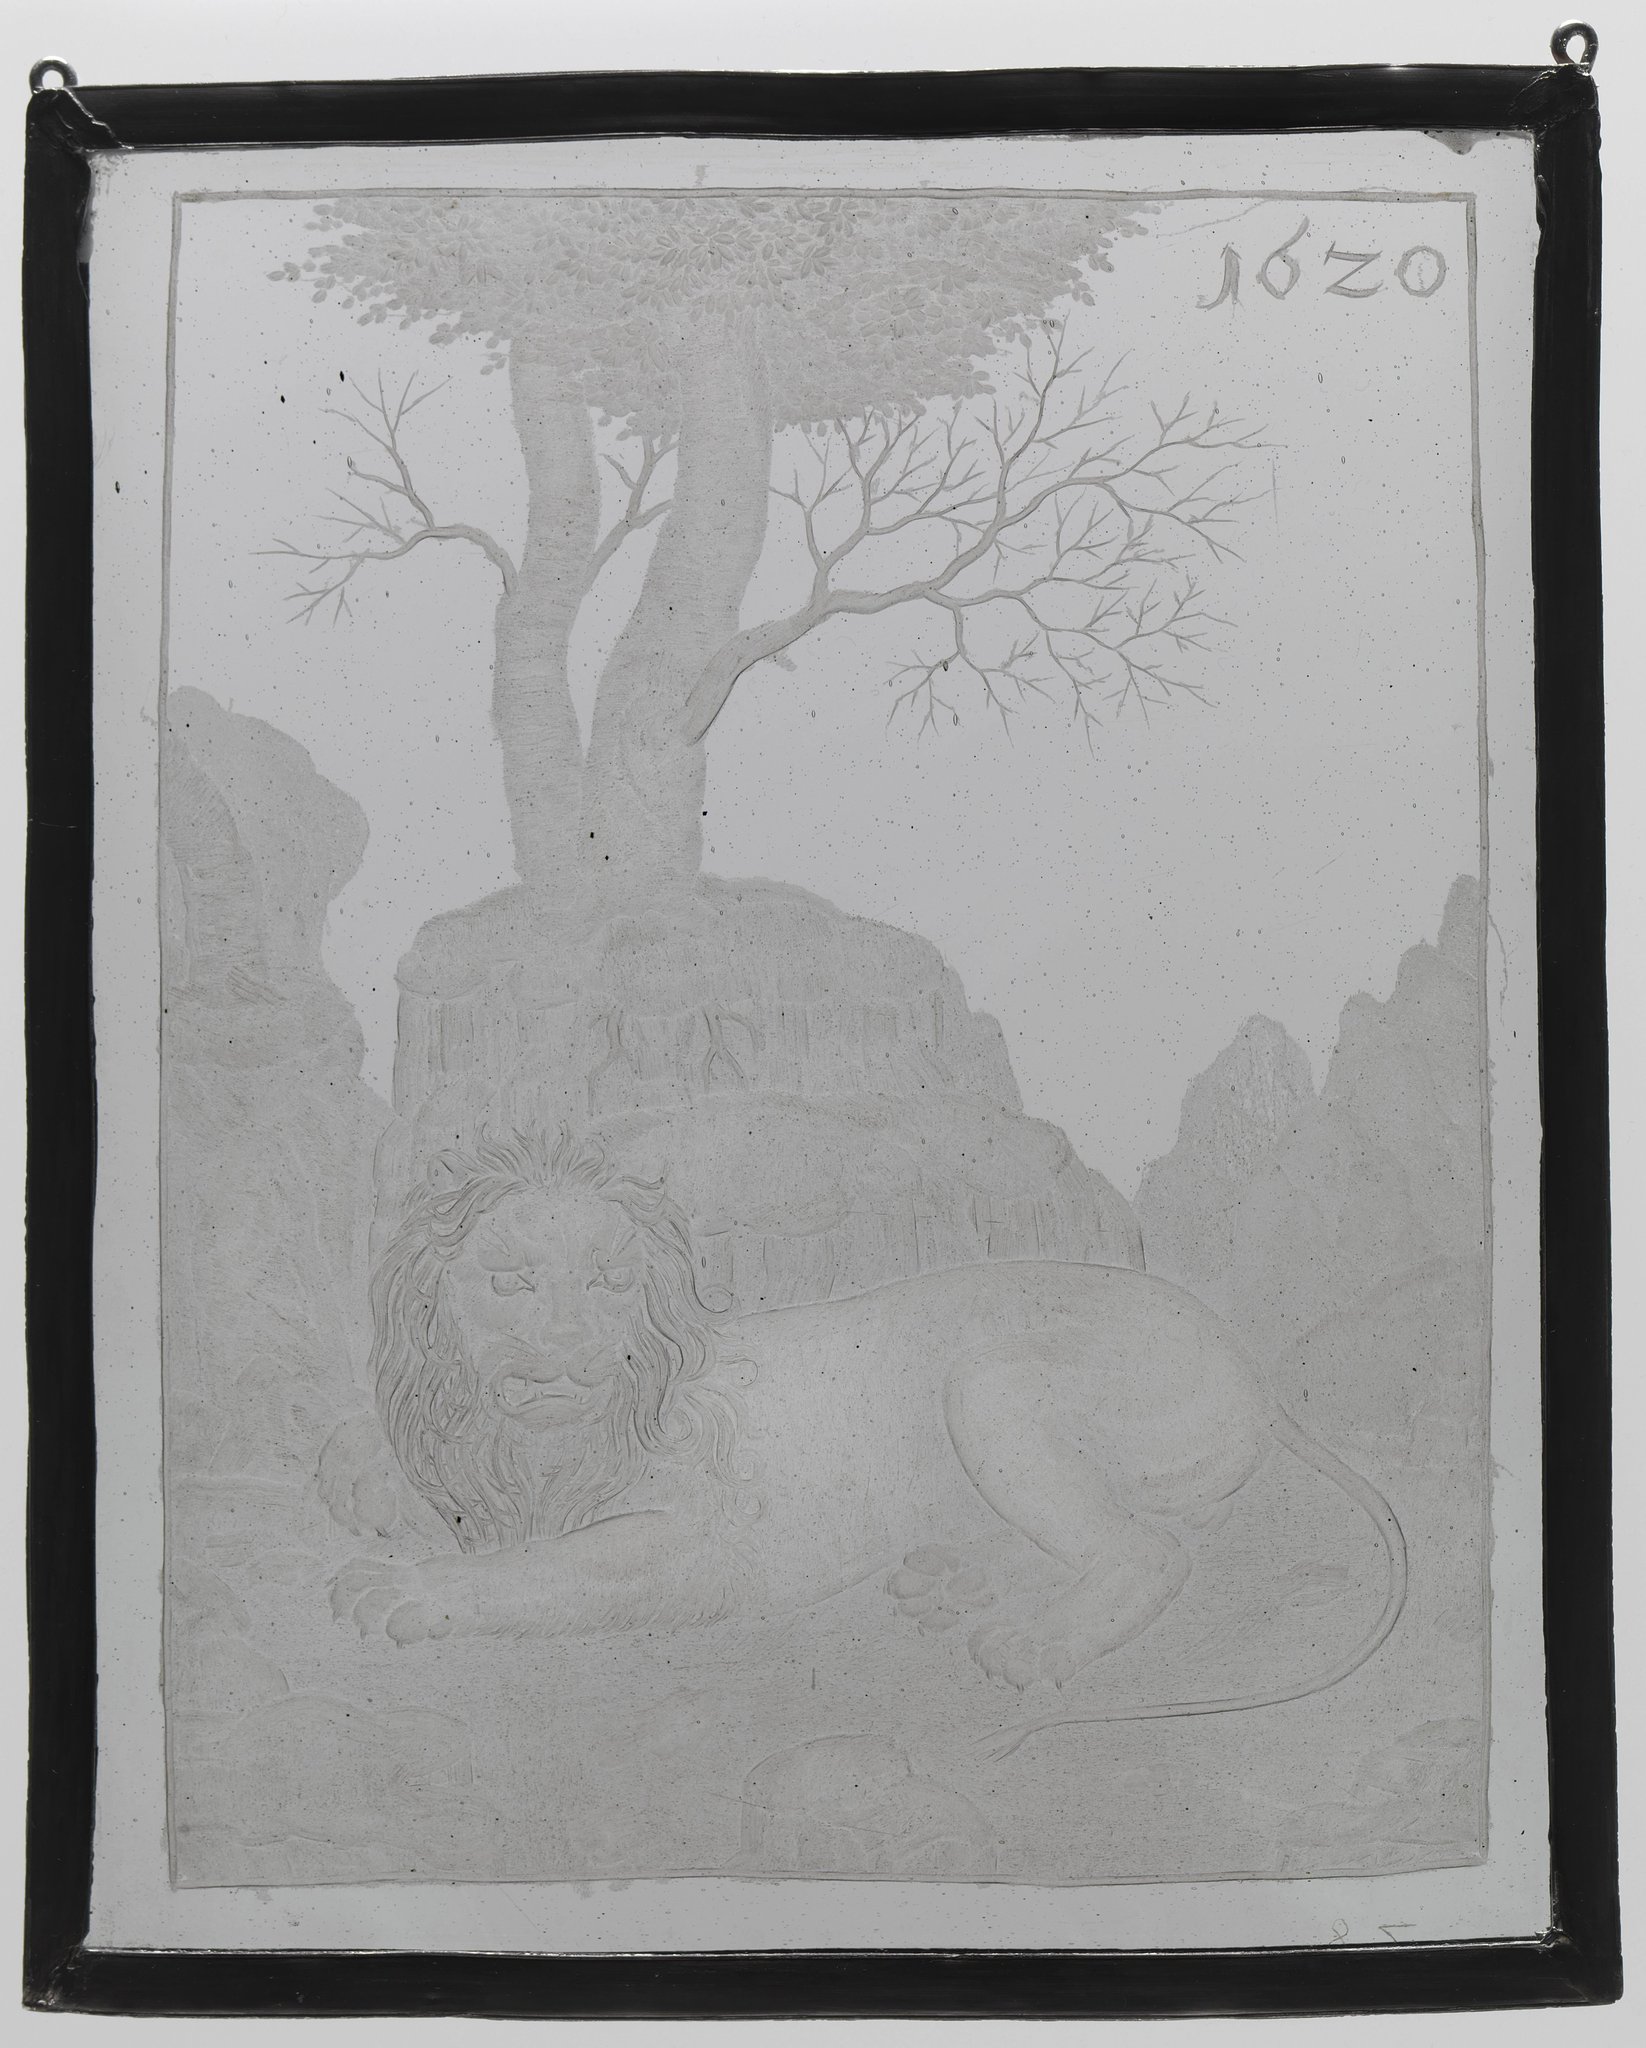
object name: light window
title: Glass pane with a lion at the foot of a tree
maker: kaspar lehmann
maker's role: glasgraveur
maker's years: 1563-1622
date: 1620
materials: glass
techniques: rotary engraving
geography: prague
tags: beasts of prey, predatory animals: lion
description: Ruit met een gegraveerde voorstelling van een leeuw aan de voet van een boom. Aan weerskanten rotsen. Rechtsboven het jaartal 1620.